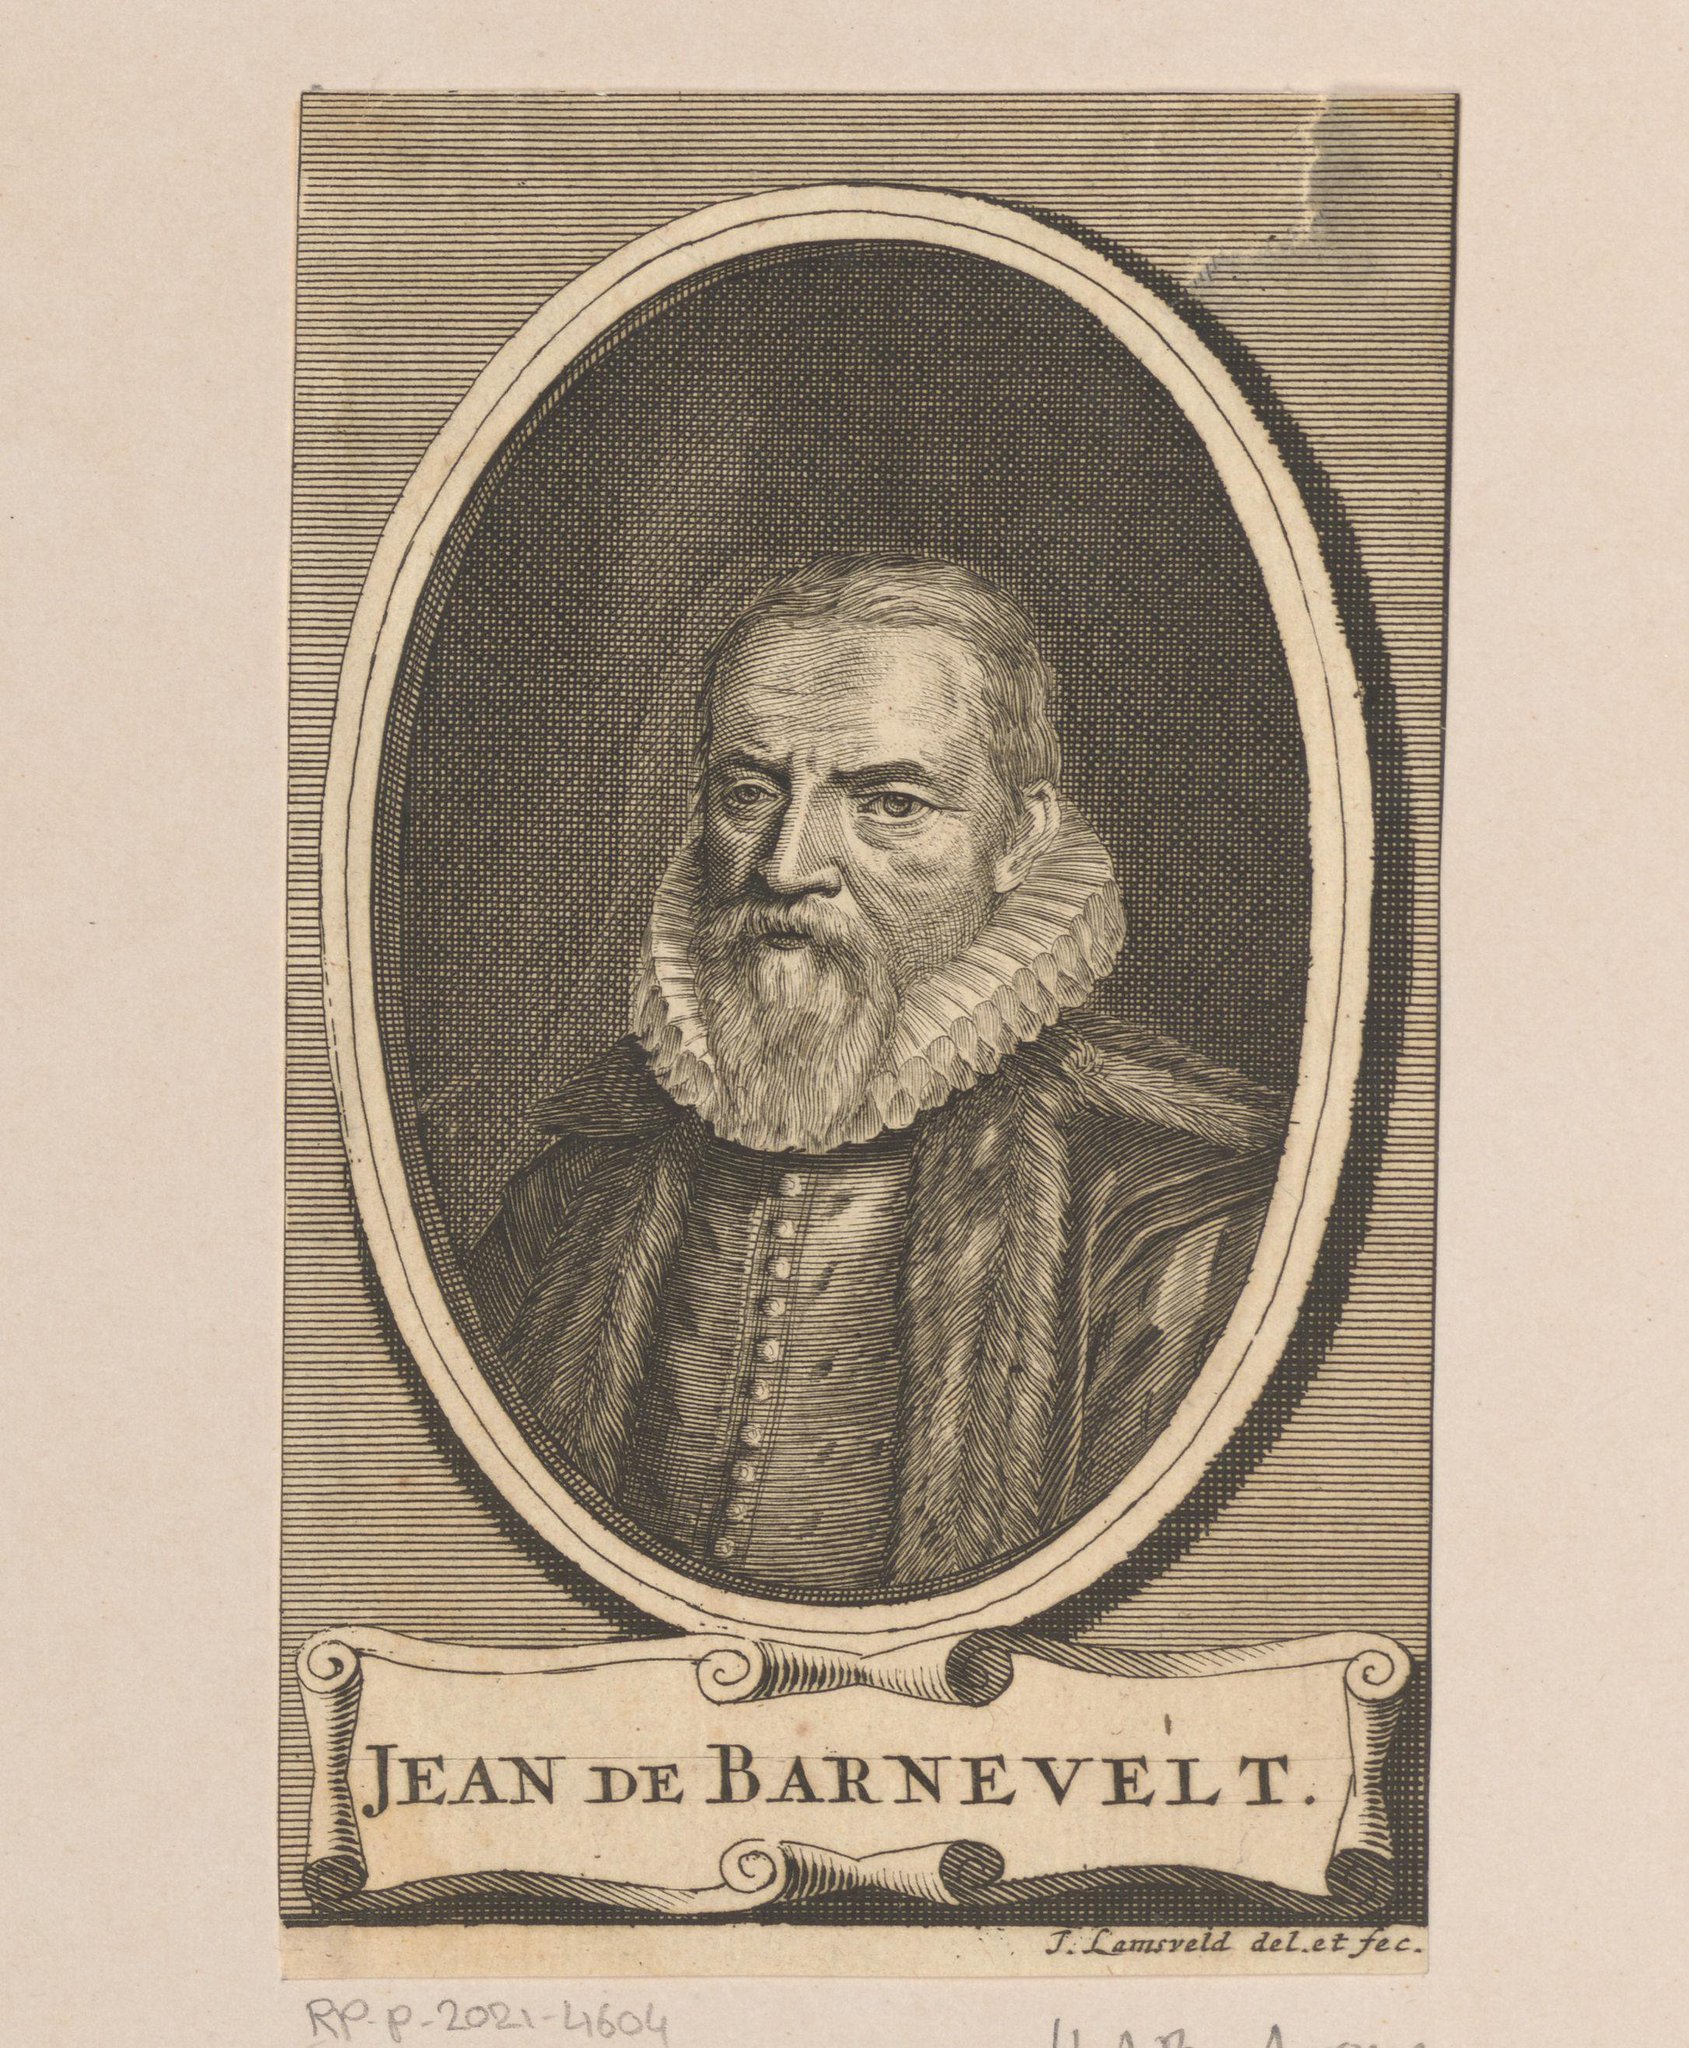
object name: print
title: Portret van Johan van Oldenbarnevelt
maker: jan lamsvelt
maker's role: print maker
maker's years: 1674-1743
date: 1696-1743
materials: paper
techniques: engraving, etching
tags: the hague, johan van oldenbarnevelt, historical persons